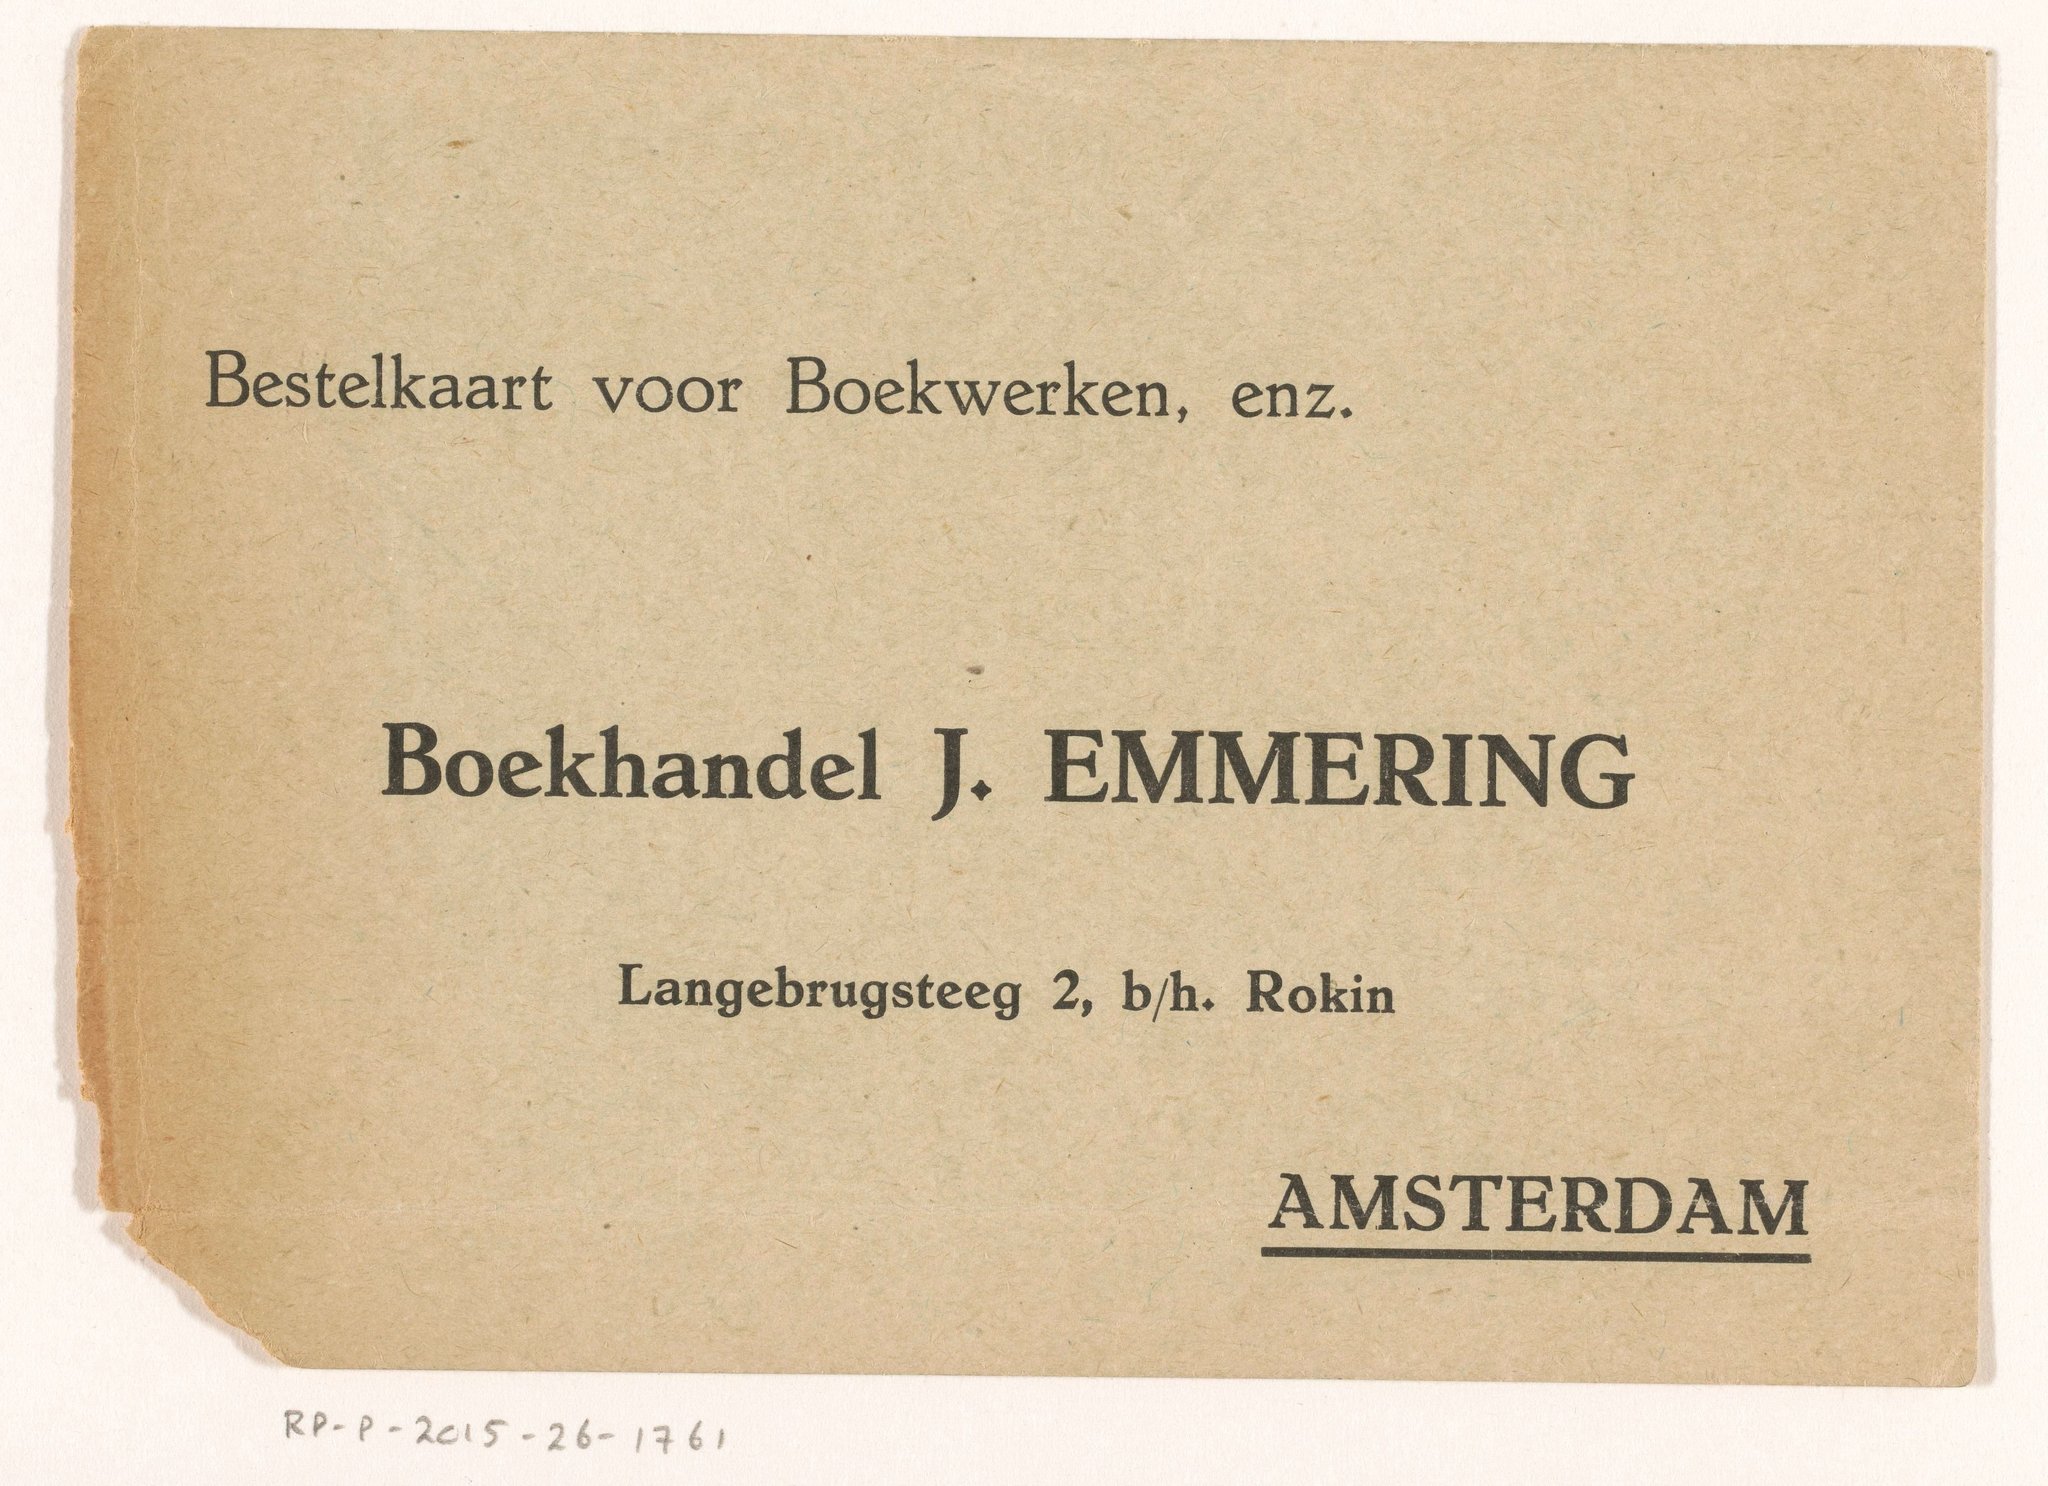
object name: print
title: Bestelkaart van boekhandel J. Emmering te Amsterdam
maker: Anonymous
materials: paper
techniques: printing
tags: amsterdam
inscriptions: collector's mark: Lugt 2228